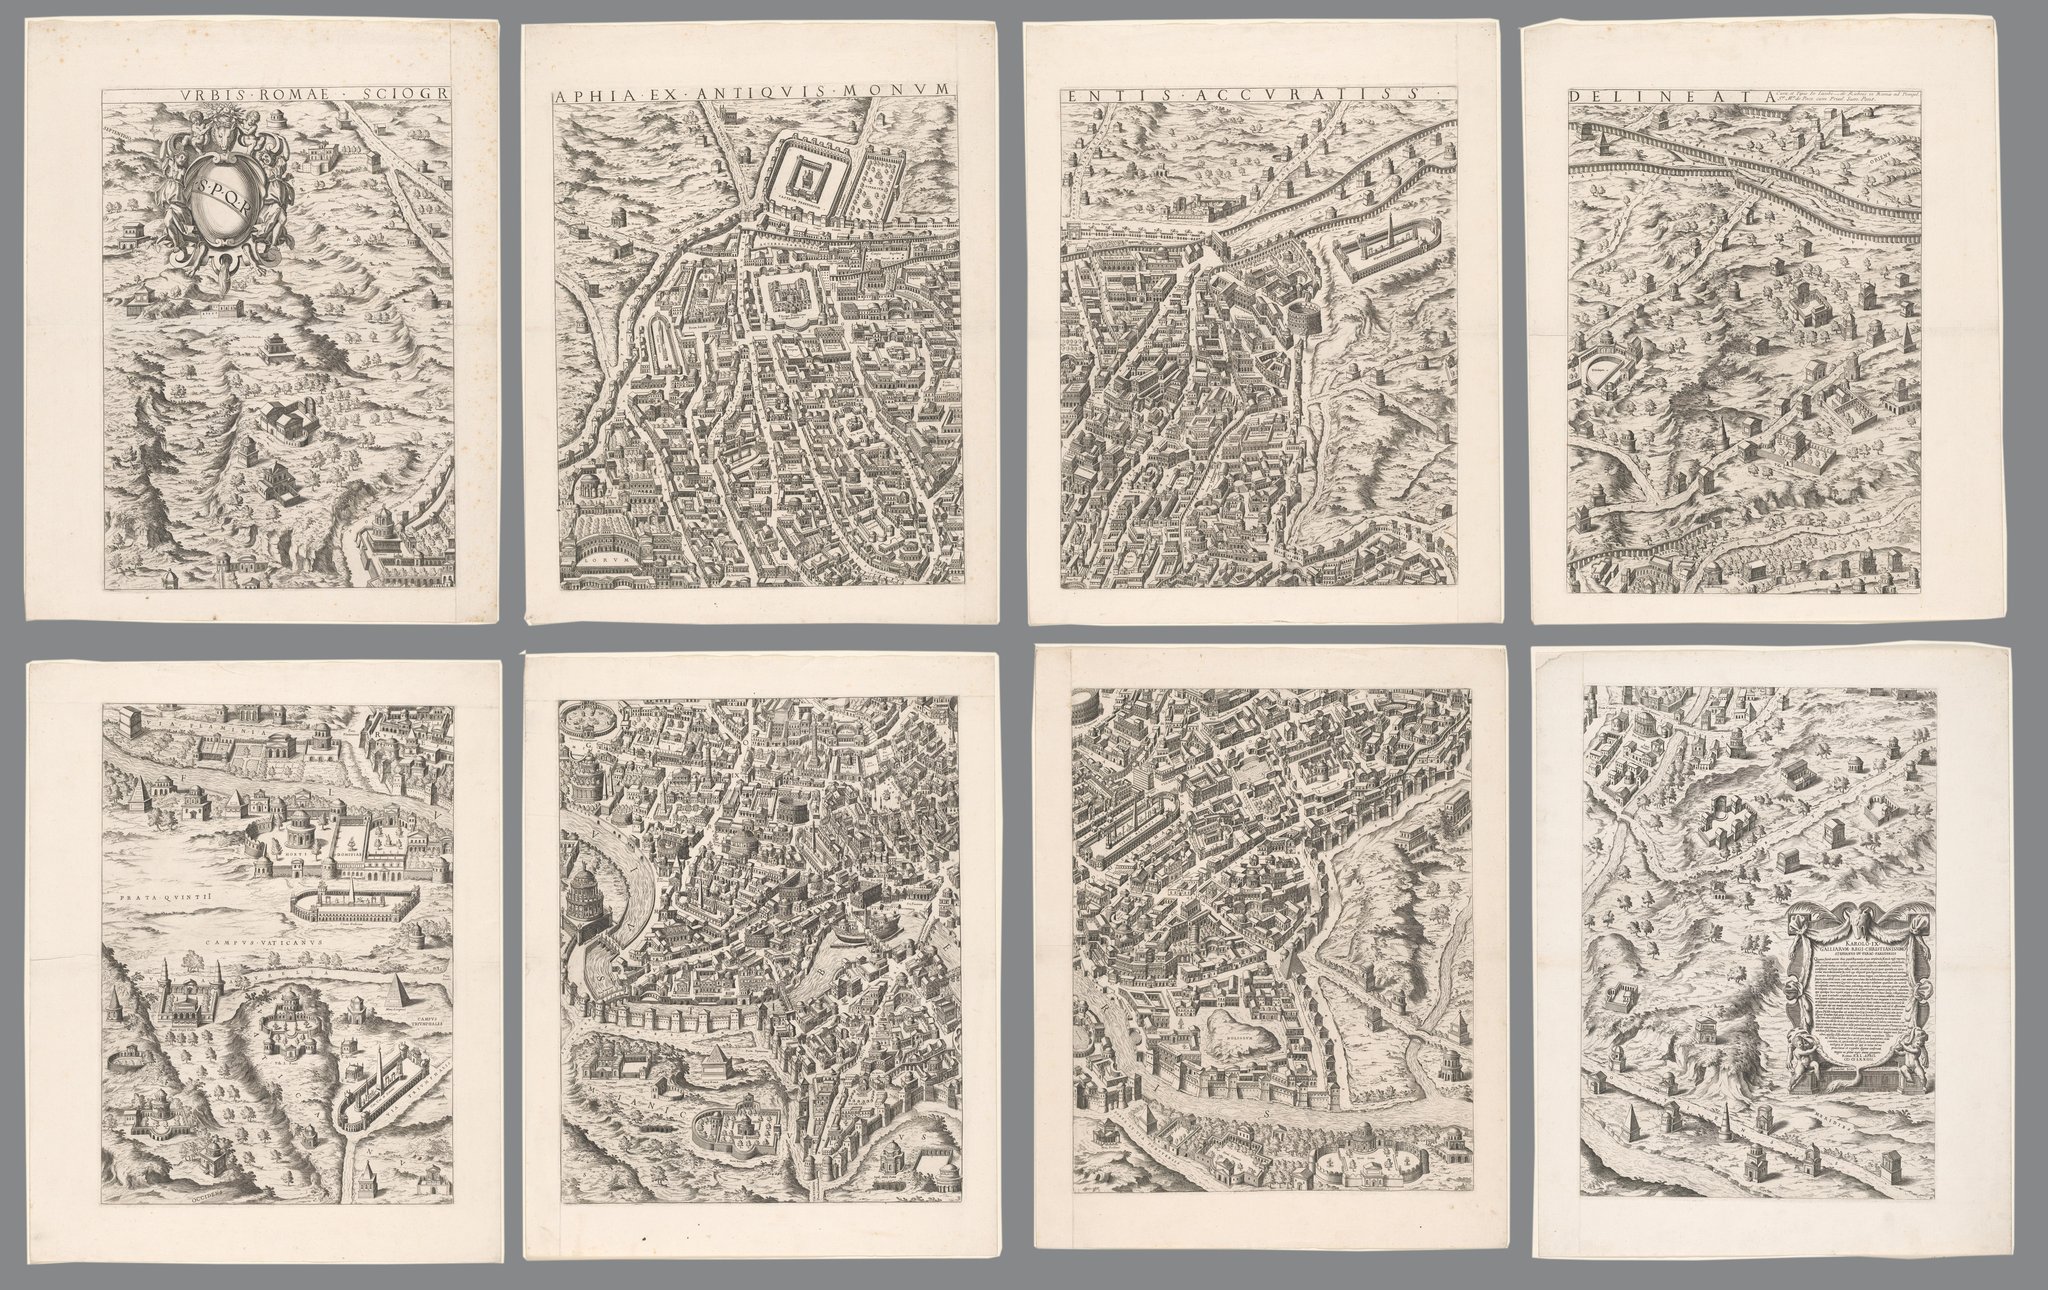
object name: print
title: Urbis Romae sciographia ex antiquis monumentis accuratiss delineata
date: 1639-1691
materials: paper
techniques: engraving, etching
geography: rome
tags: (story of) romulus and remus, temple, shrine ~ roman religion, maps of cities, rome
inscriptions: collector's mark: Lugt 2228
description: Dit object is omwille van een betere presentatie virtueel samengevoegd maar bestaat fysiek uit losse onderdelen.